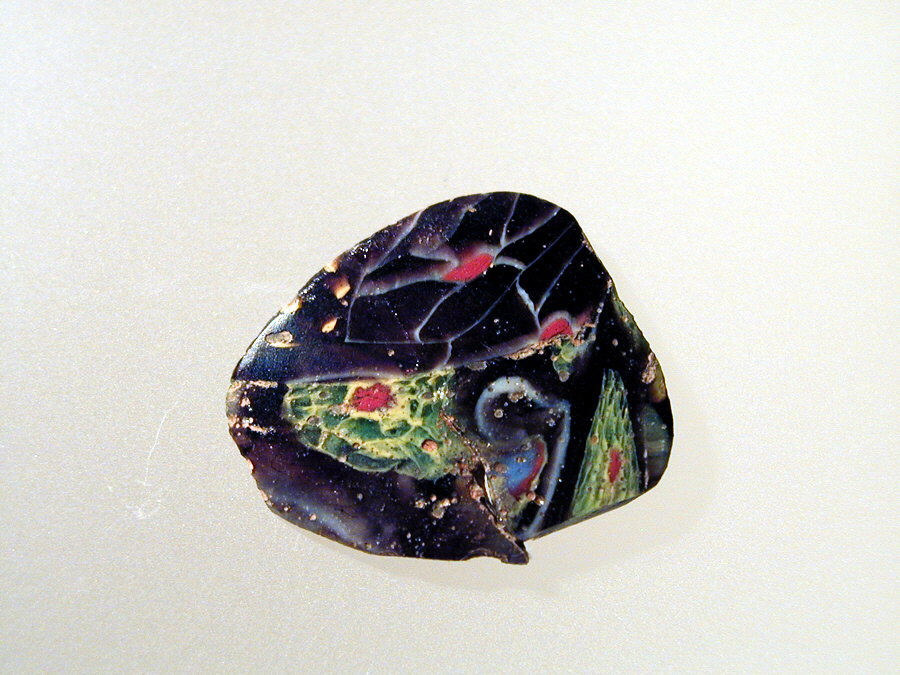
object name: fragment, mosaic bowl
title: Glass mosaic bowl fragment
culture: roman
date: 34 BCE-33 CE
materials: glass